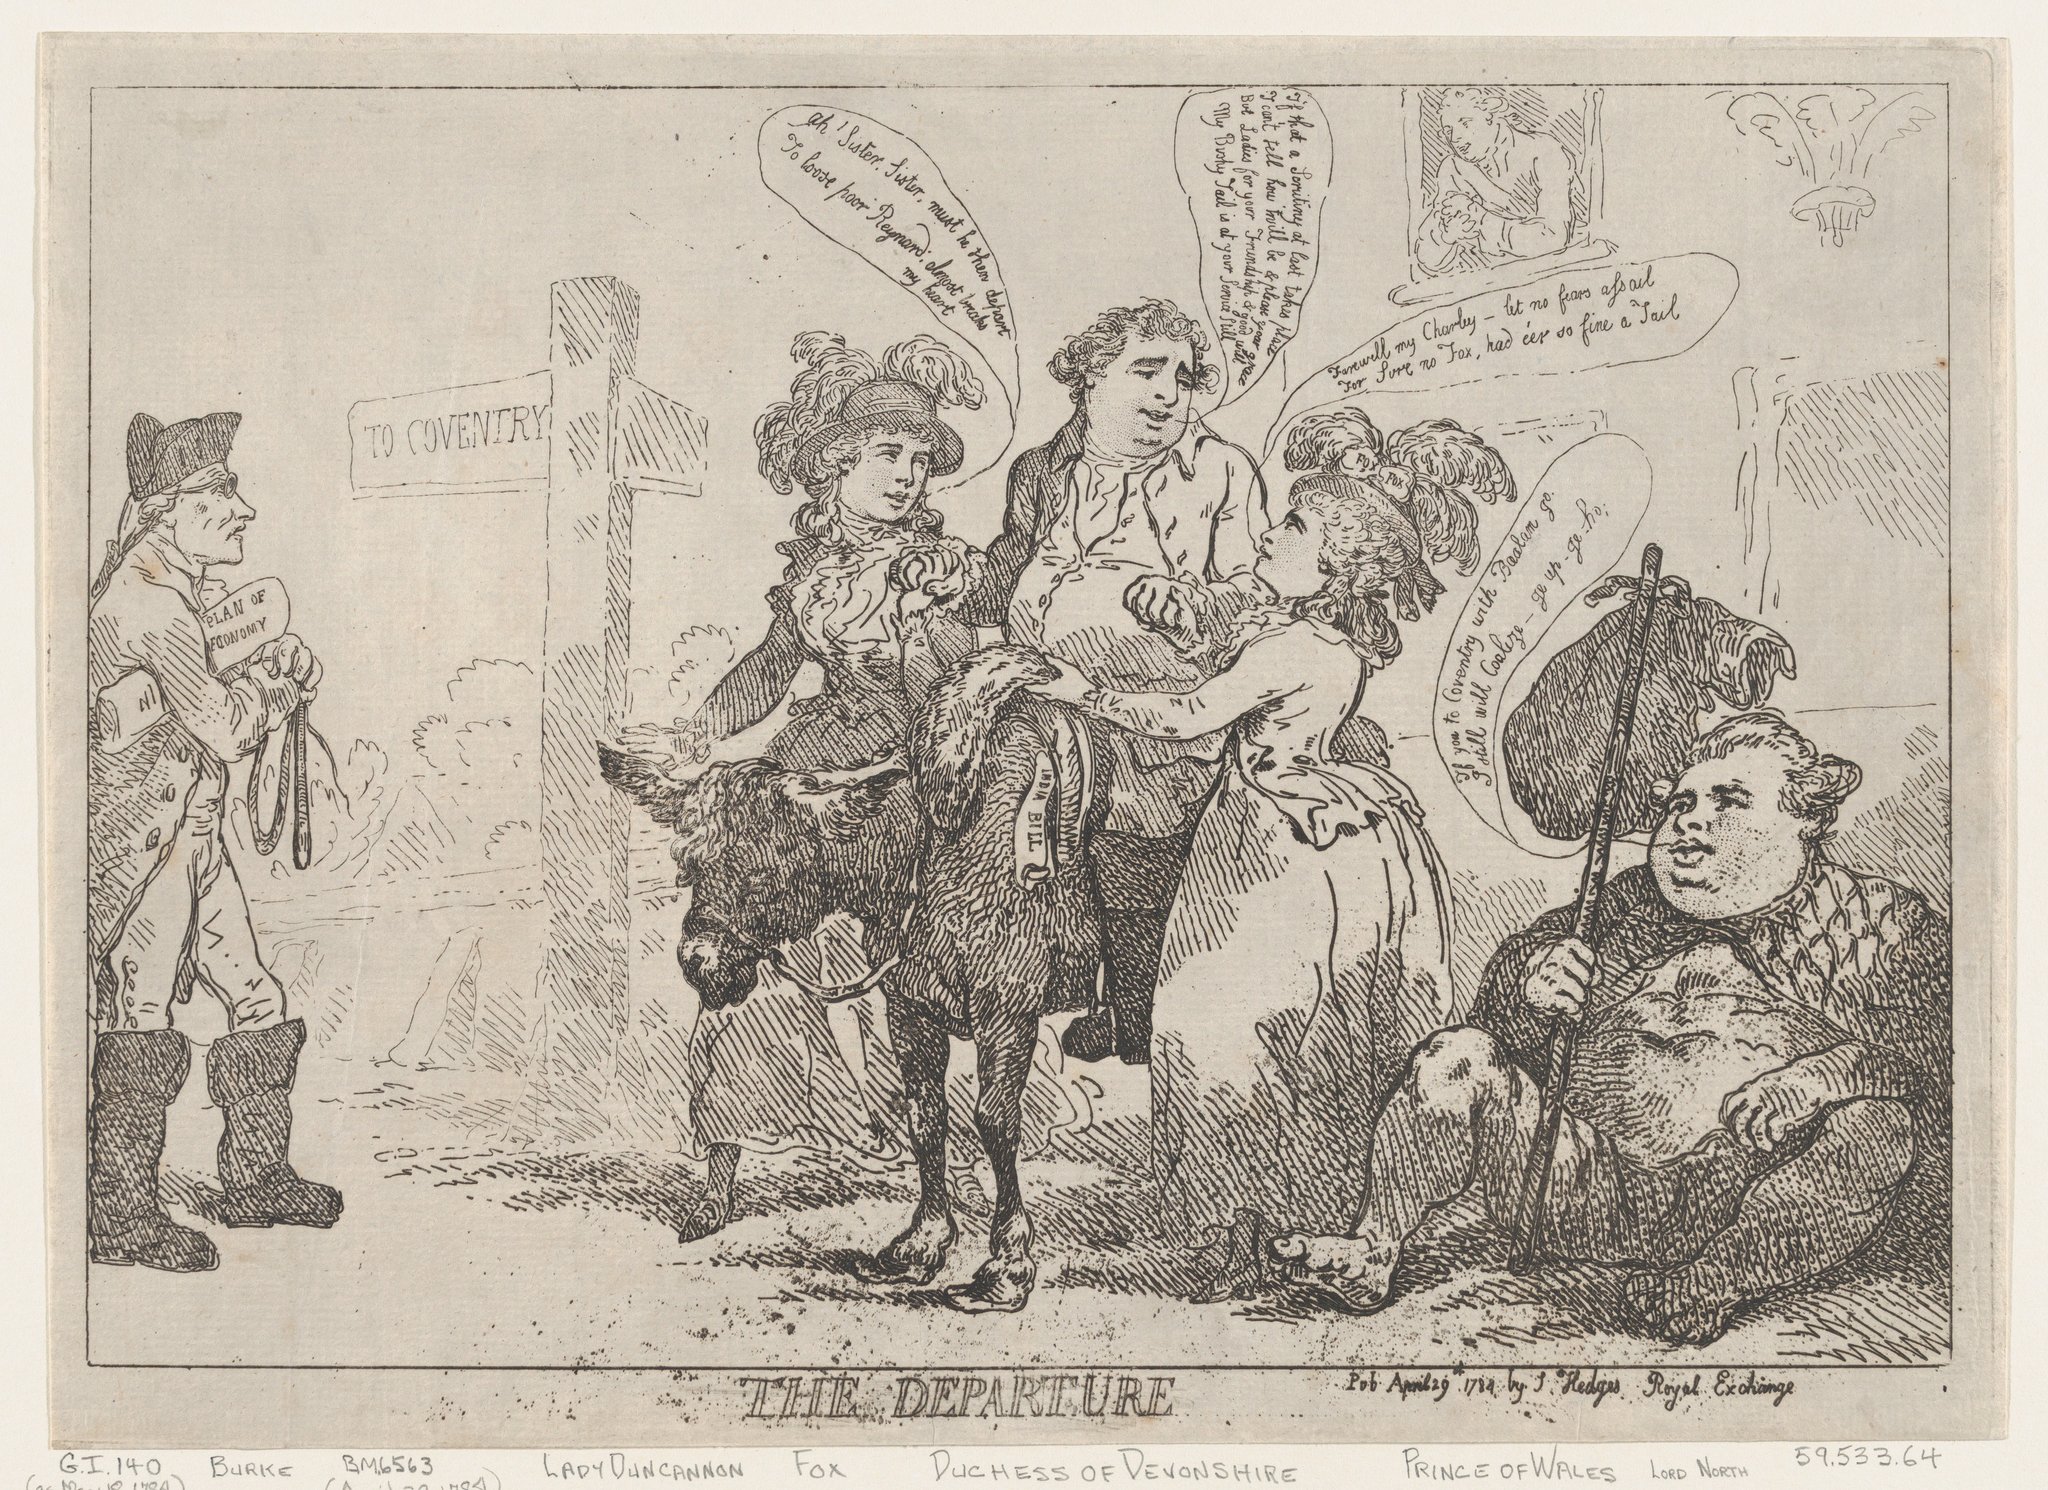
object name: print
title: The Departure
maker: thomas rowlandson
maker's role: artist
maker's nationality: british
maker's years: 1757-1827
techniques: etching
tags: satire,men,women,donkeys,politics